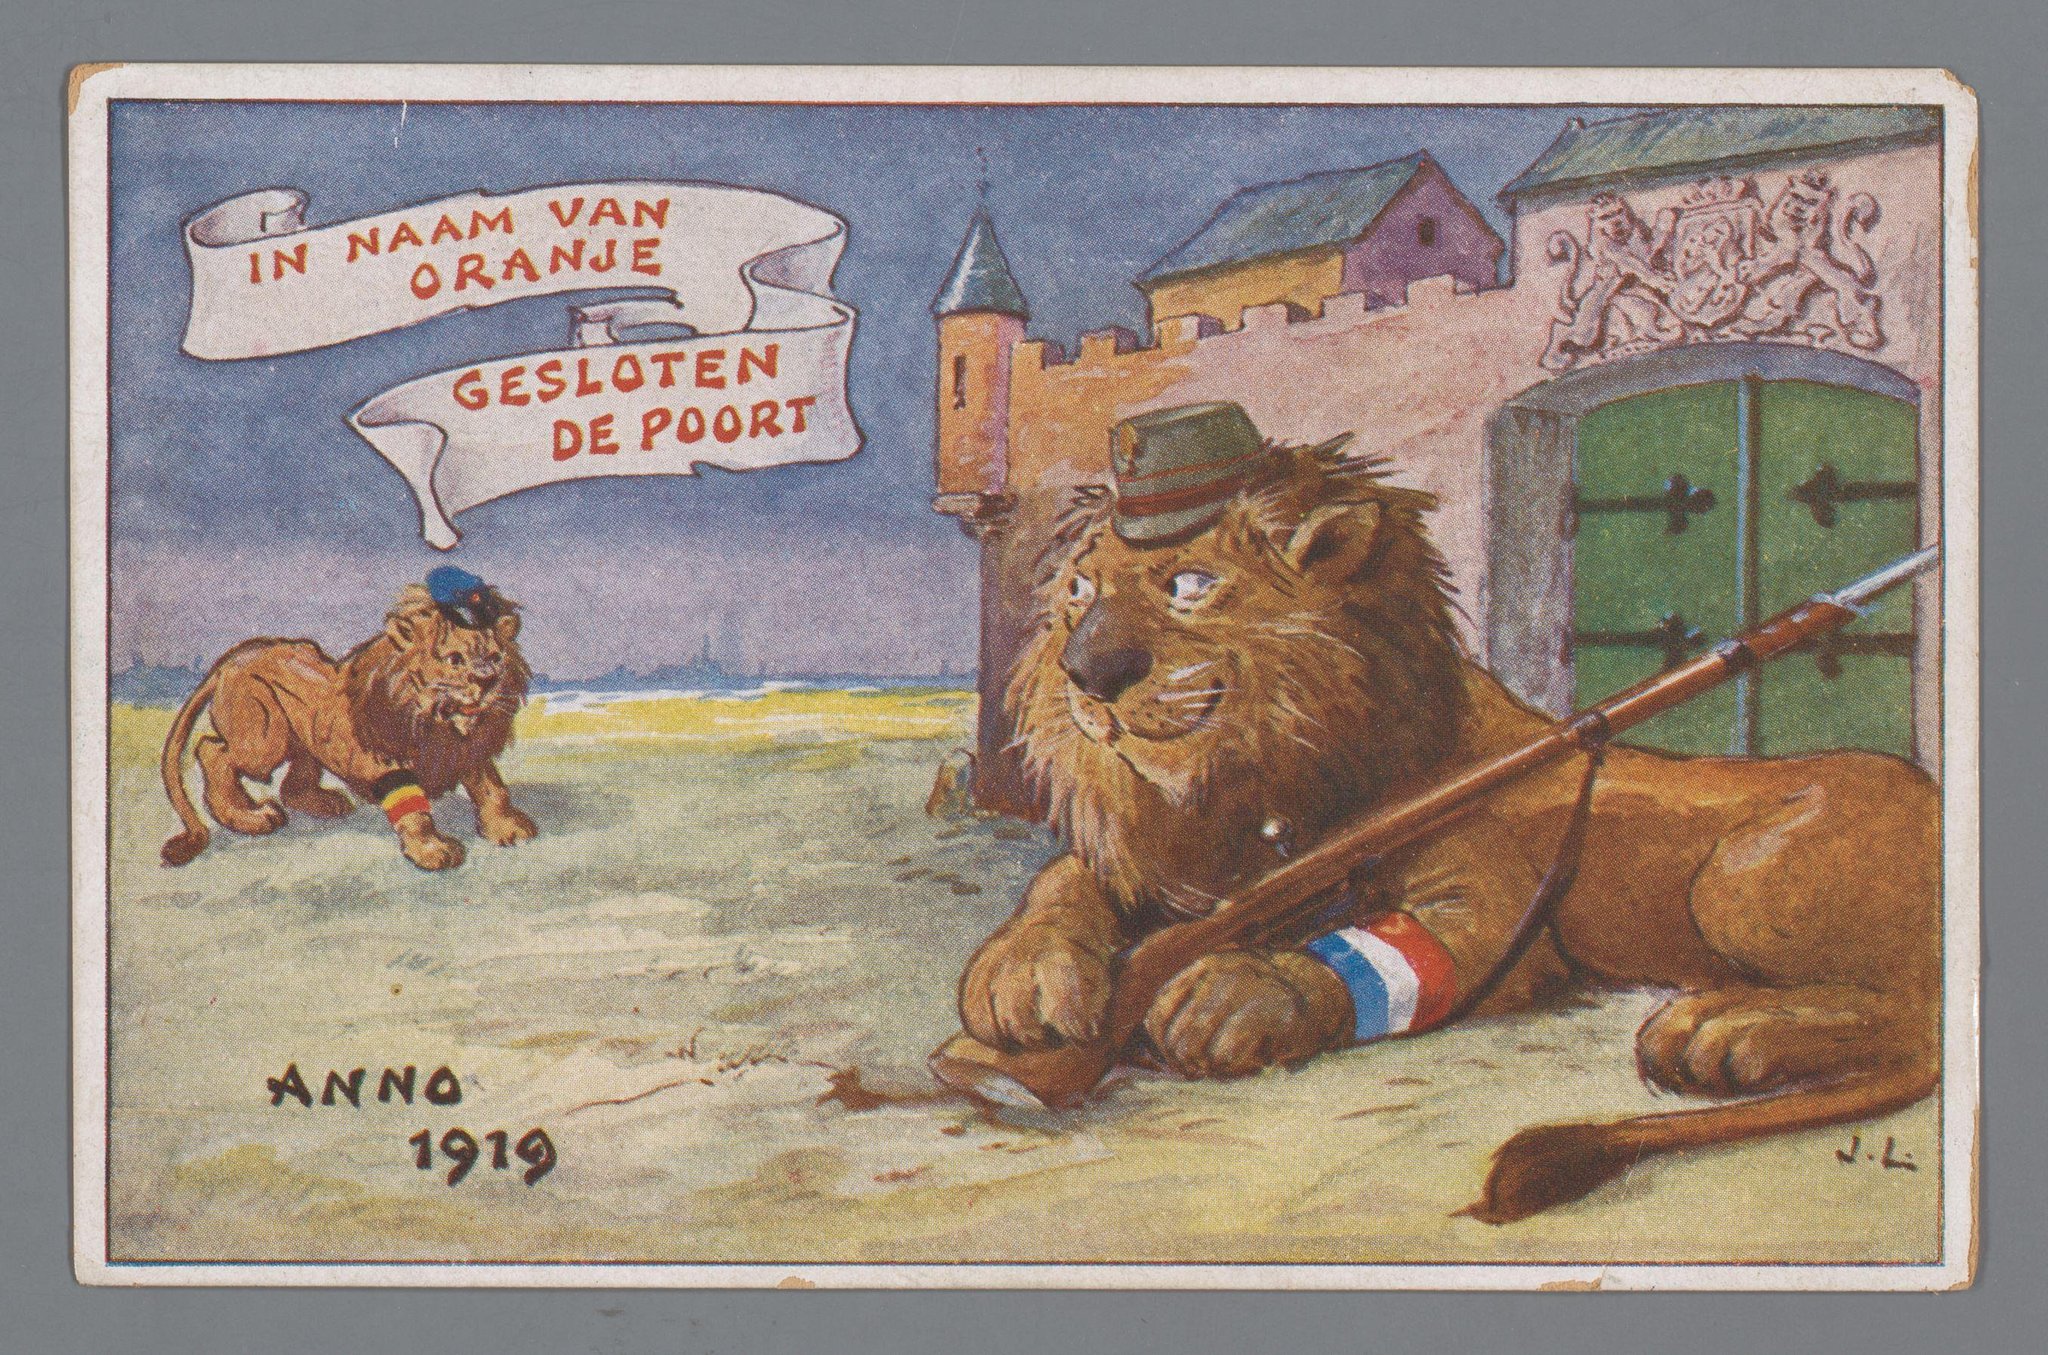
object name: postcard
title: In naam van Oranje gesloten de poort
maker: w. den boer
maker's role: publisher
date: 1919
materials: paper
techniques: printing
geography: bussum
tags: netherlands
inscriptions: inscription: ‘IN NAAM VAN / ORANJE / GESLOTEN / DE POORT’, date: ‘Anno 1919’, signature: ‘J.L.’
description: Een leeuw met geweer, Nederlandse kepi en rood-wit-blauwe bandeau om de poot bewaakt kasteel waarop het Nederlandse wapen. Links ongewapende Belgische leeuw met Belgische kepi en zwart-geel-rode bandeau om de poot.